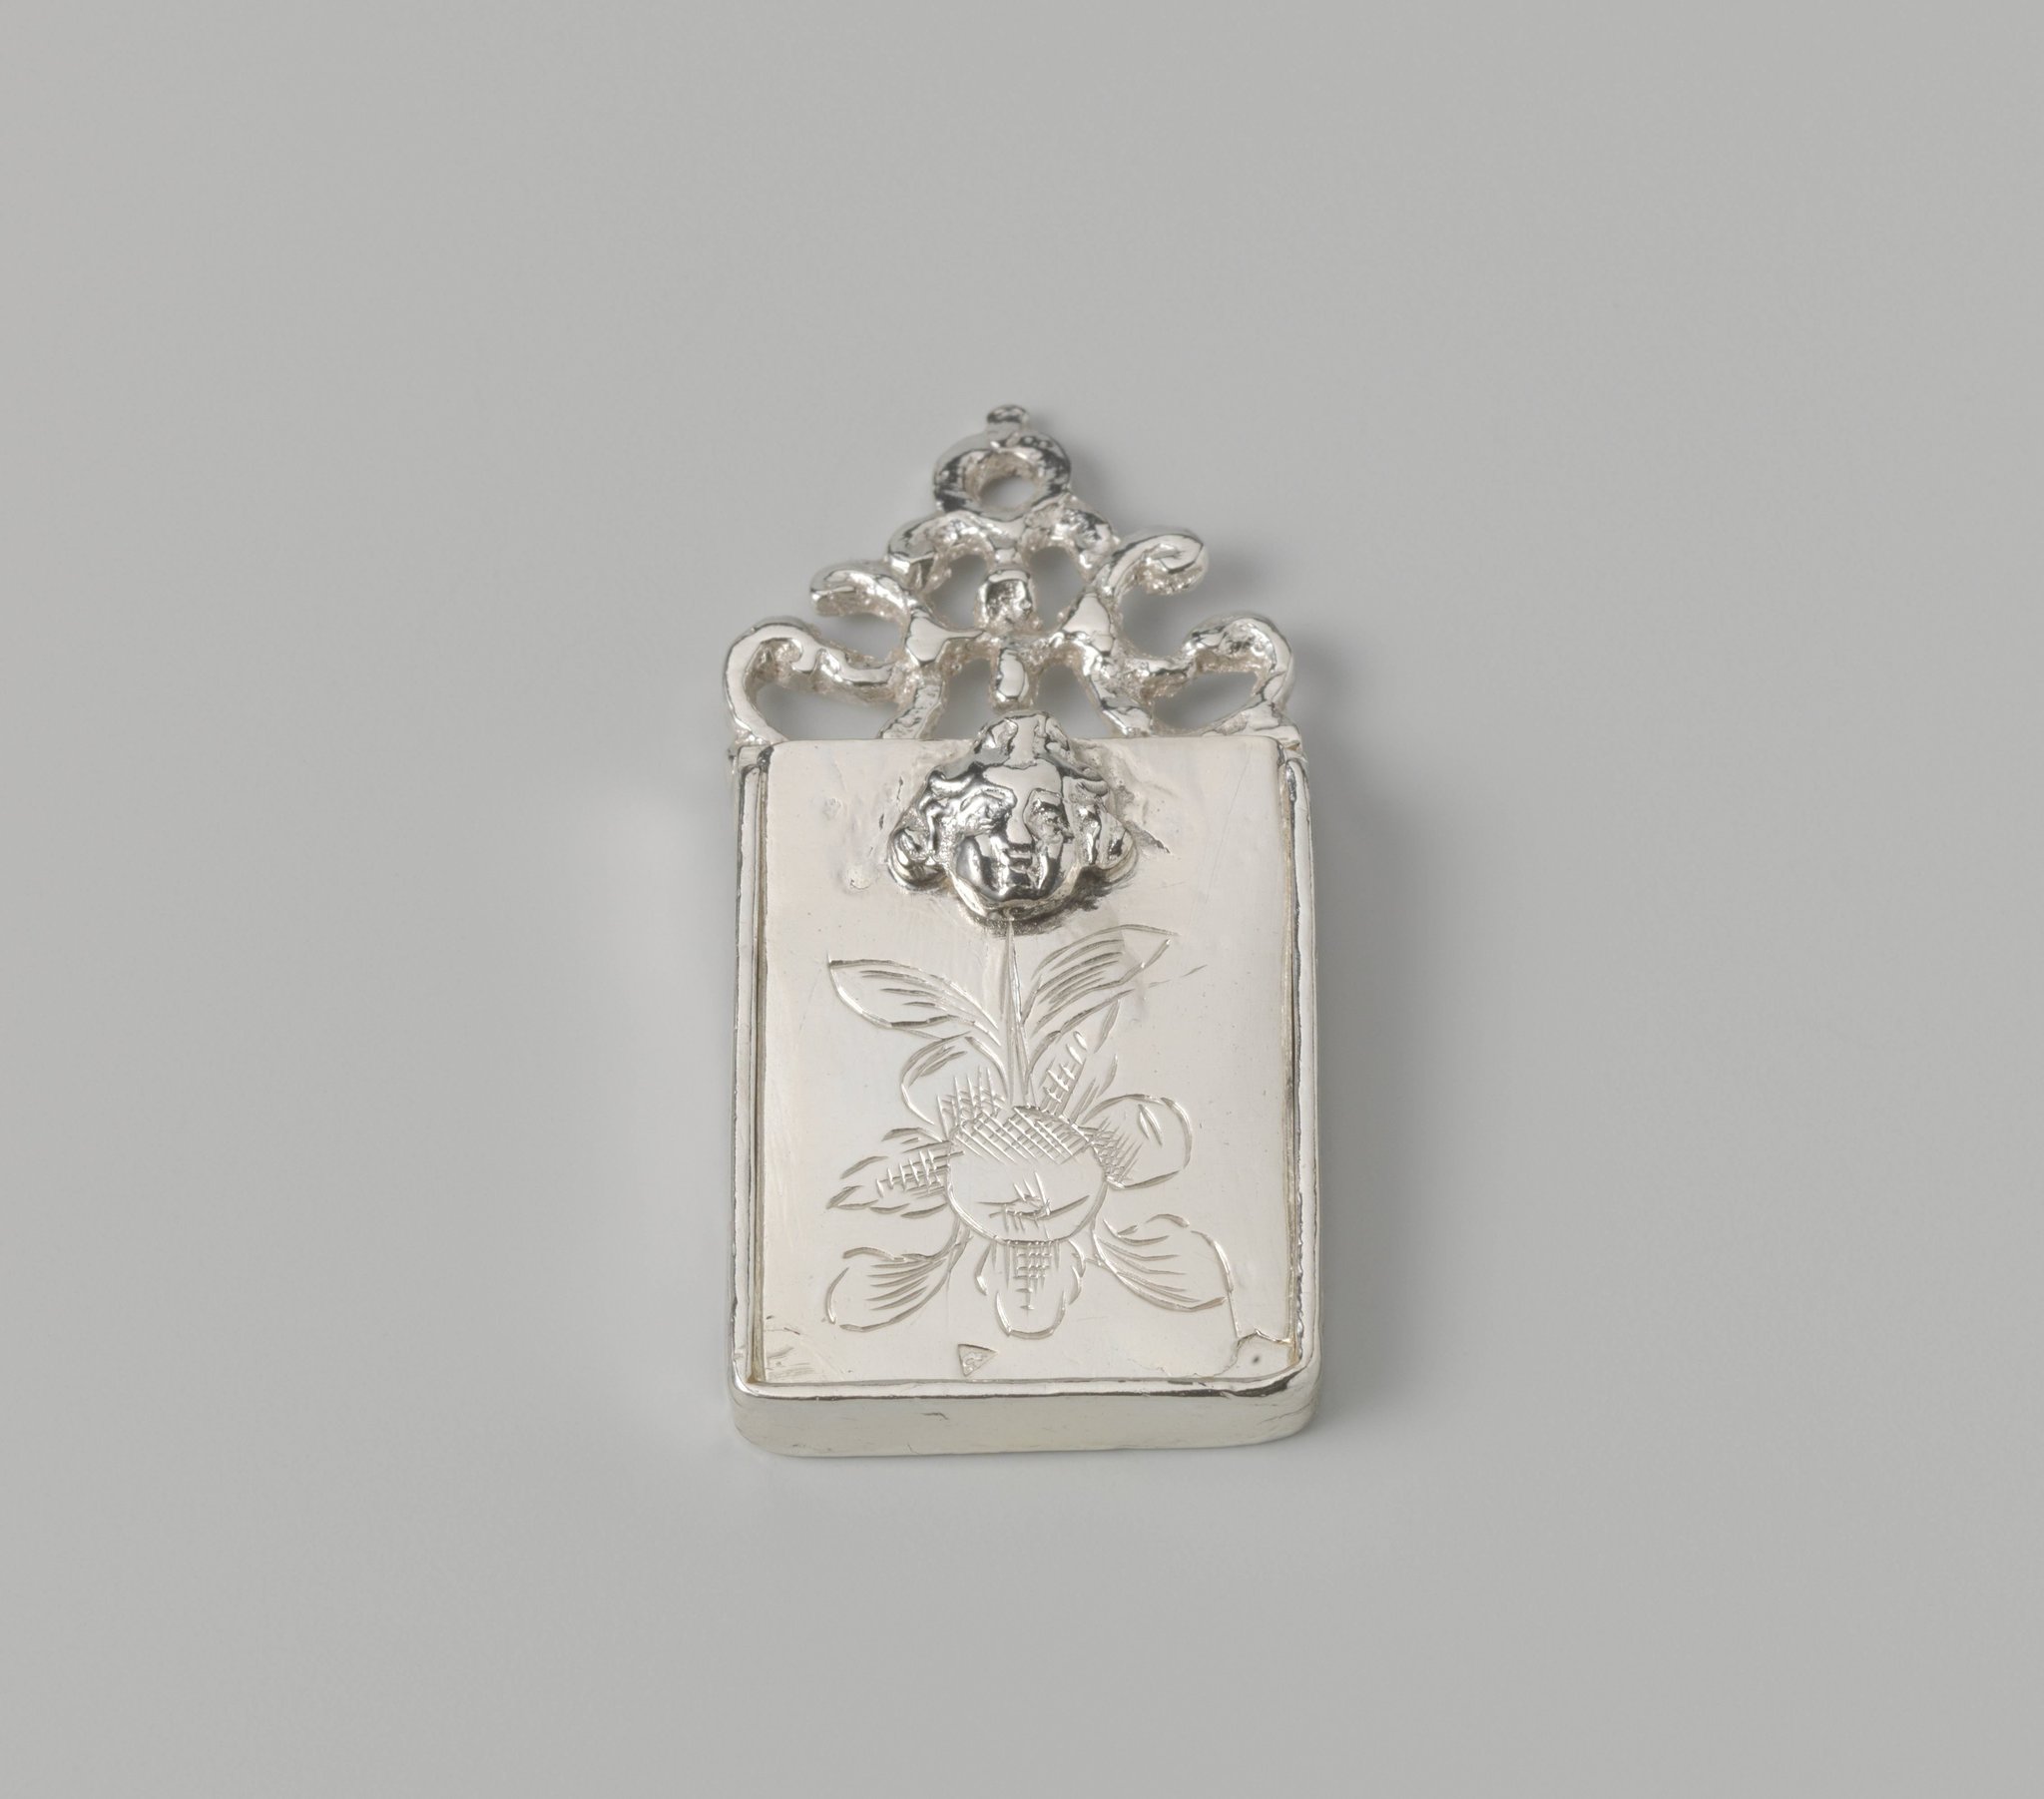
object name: miniature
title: Schooltas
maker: Anonymous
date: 1600-1699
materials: silver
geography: netherlands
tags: bag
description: Rechthoekige schooltas, met opengewerkte bovenkant, met daarin een draagoog. Op de schuifplaat is een tak gegraveerd en er is een kinderkop op bevestigd. De schooltas is gemerkt: tweemaal een dolfijn in een driehoek en de gegraveerde letters AW.